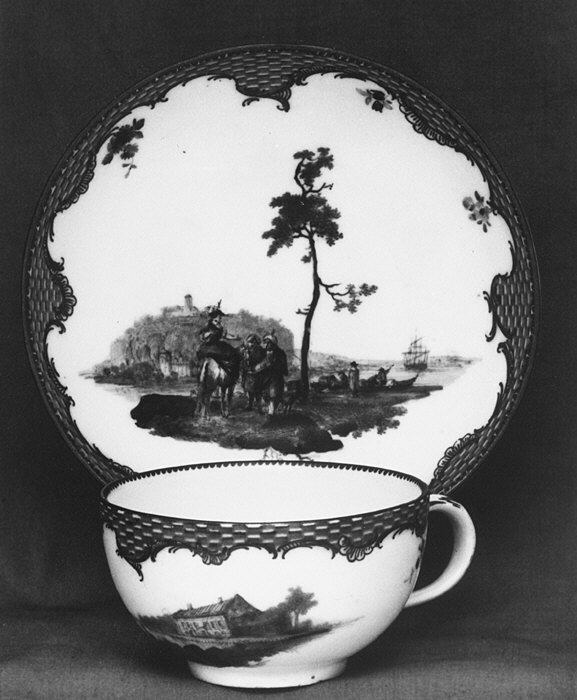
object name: cup and saucer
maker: meissen manufactory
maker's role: manufactory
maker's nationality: german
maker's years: 1710-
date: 1763-1774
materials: hard paste porcelain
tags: human figures,houses,trees